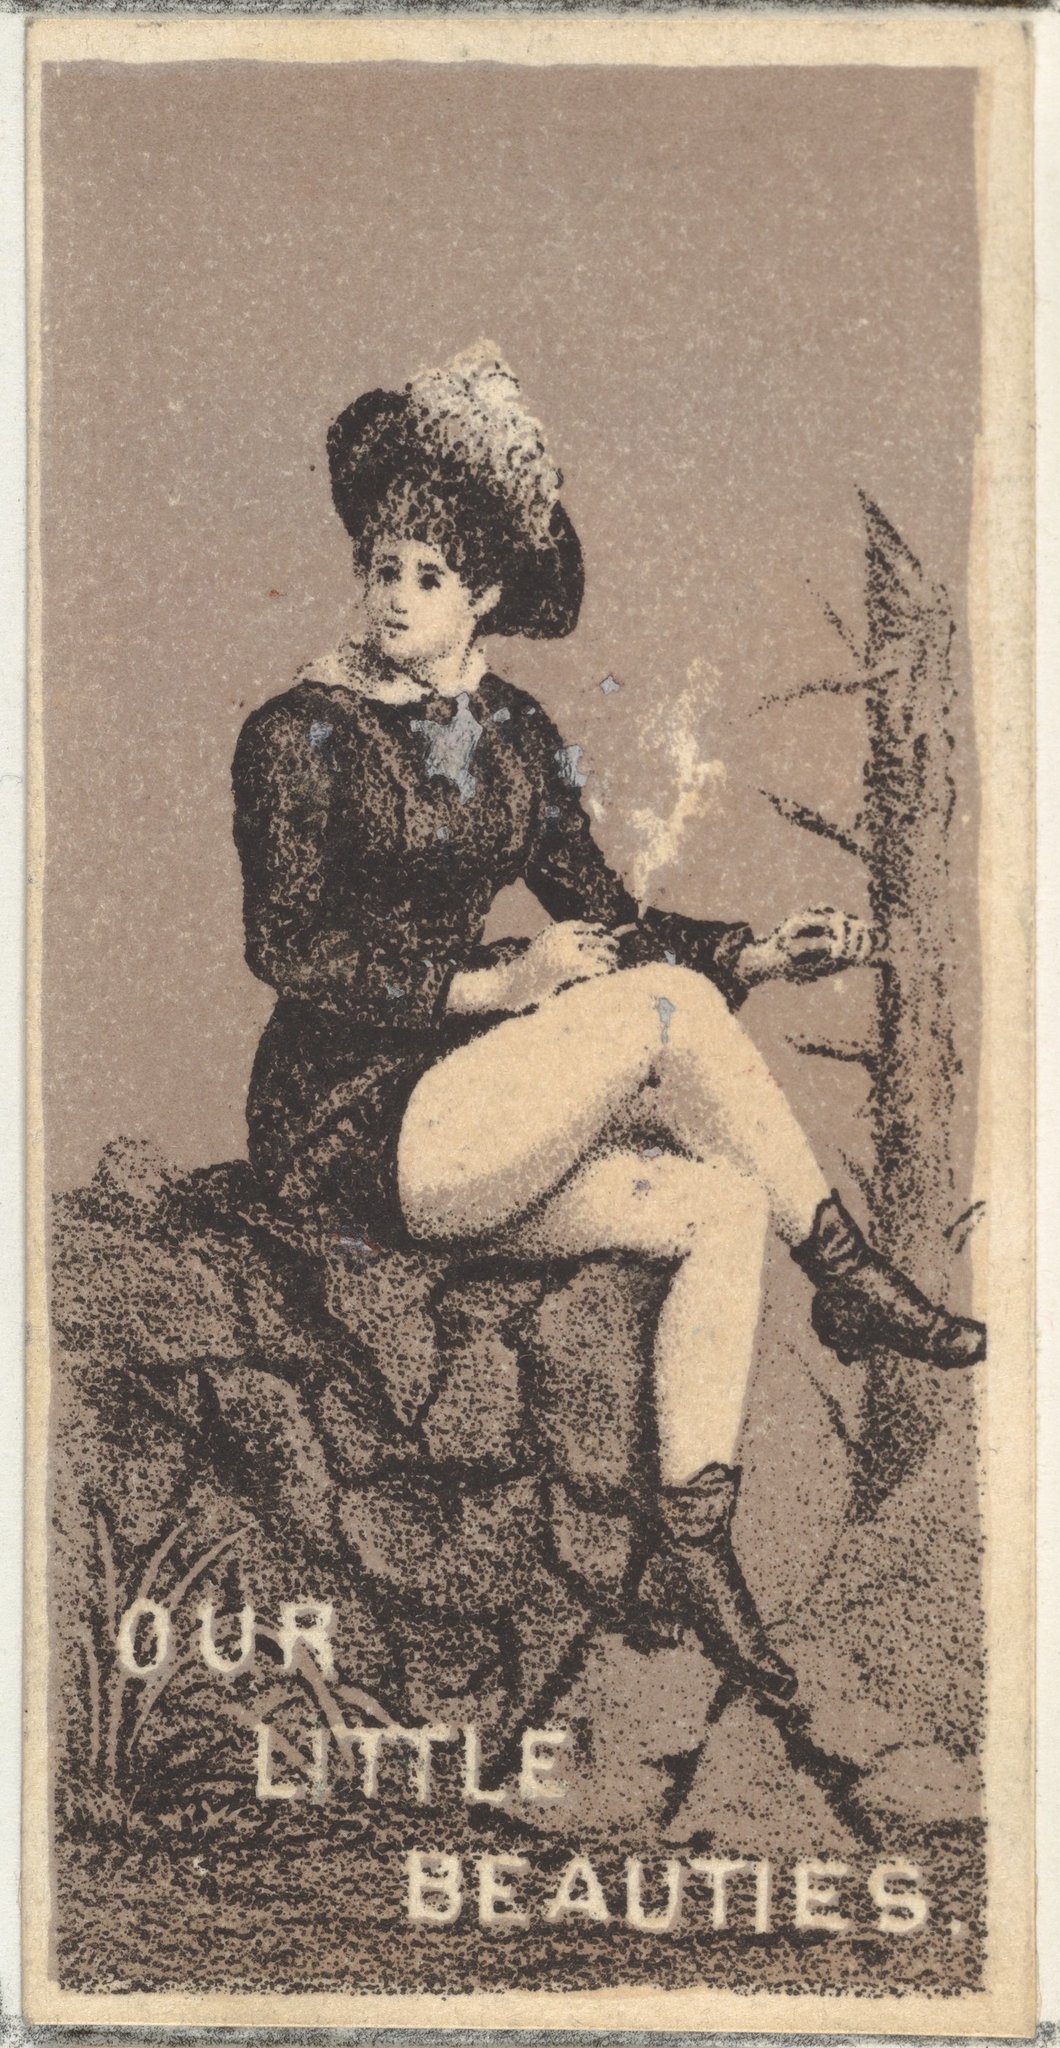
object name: print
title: From the Actresses series (N57) promoting Our Little Beauties Cigarettes for Allen & Ginter brand tobacco products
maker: allen & ginter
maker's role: publisher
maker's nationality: american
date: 1890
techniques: photolithograph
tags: portraits,women,smoking,actresses